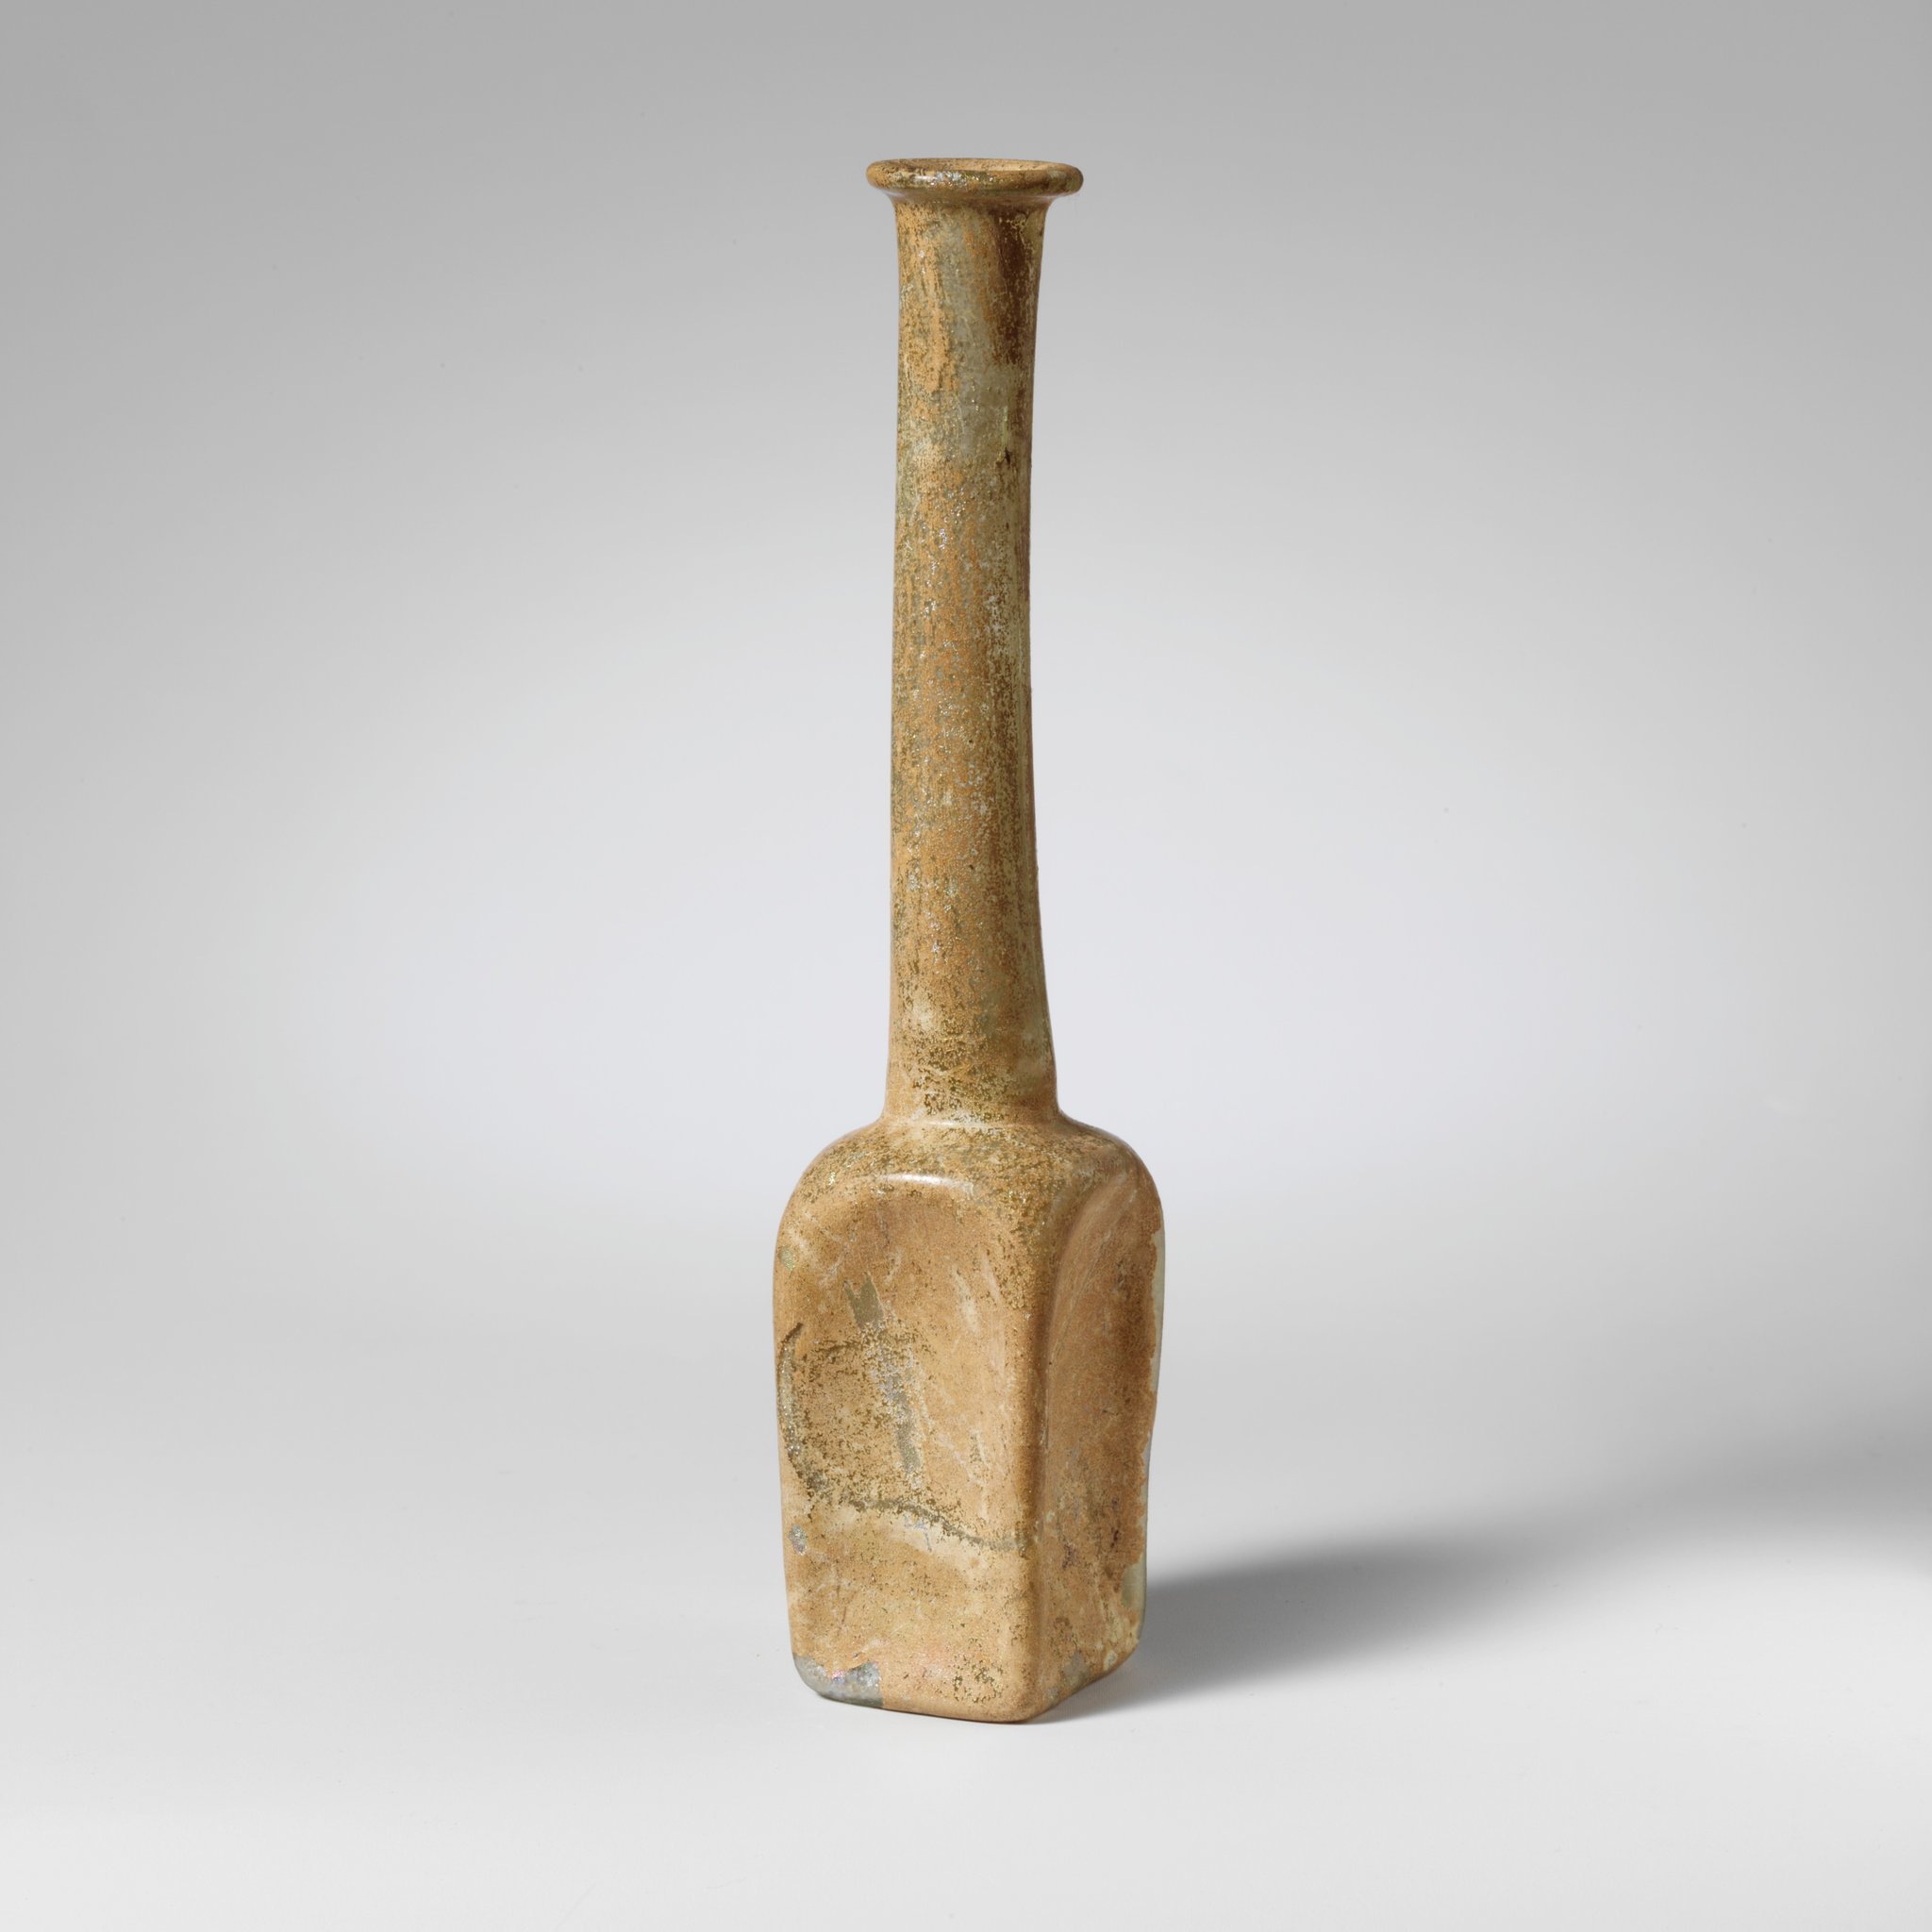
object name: bottle, four sided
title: Glass perfume bottle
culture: roman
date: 101-300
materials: glass